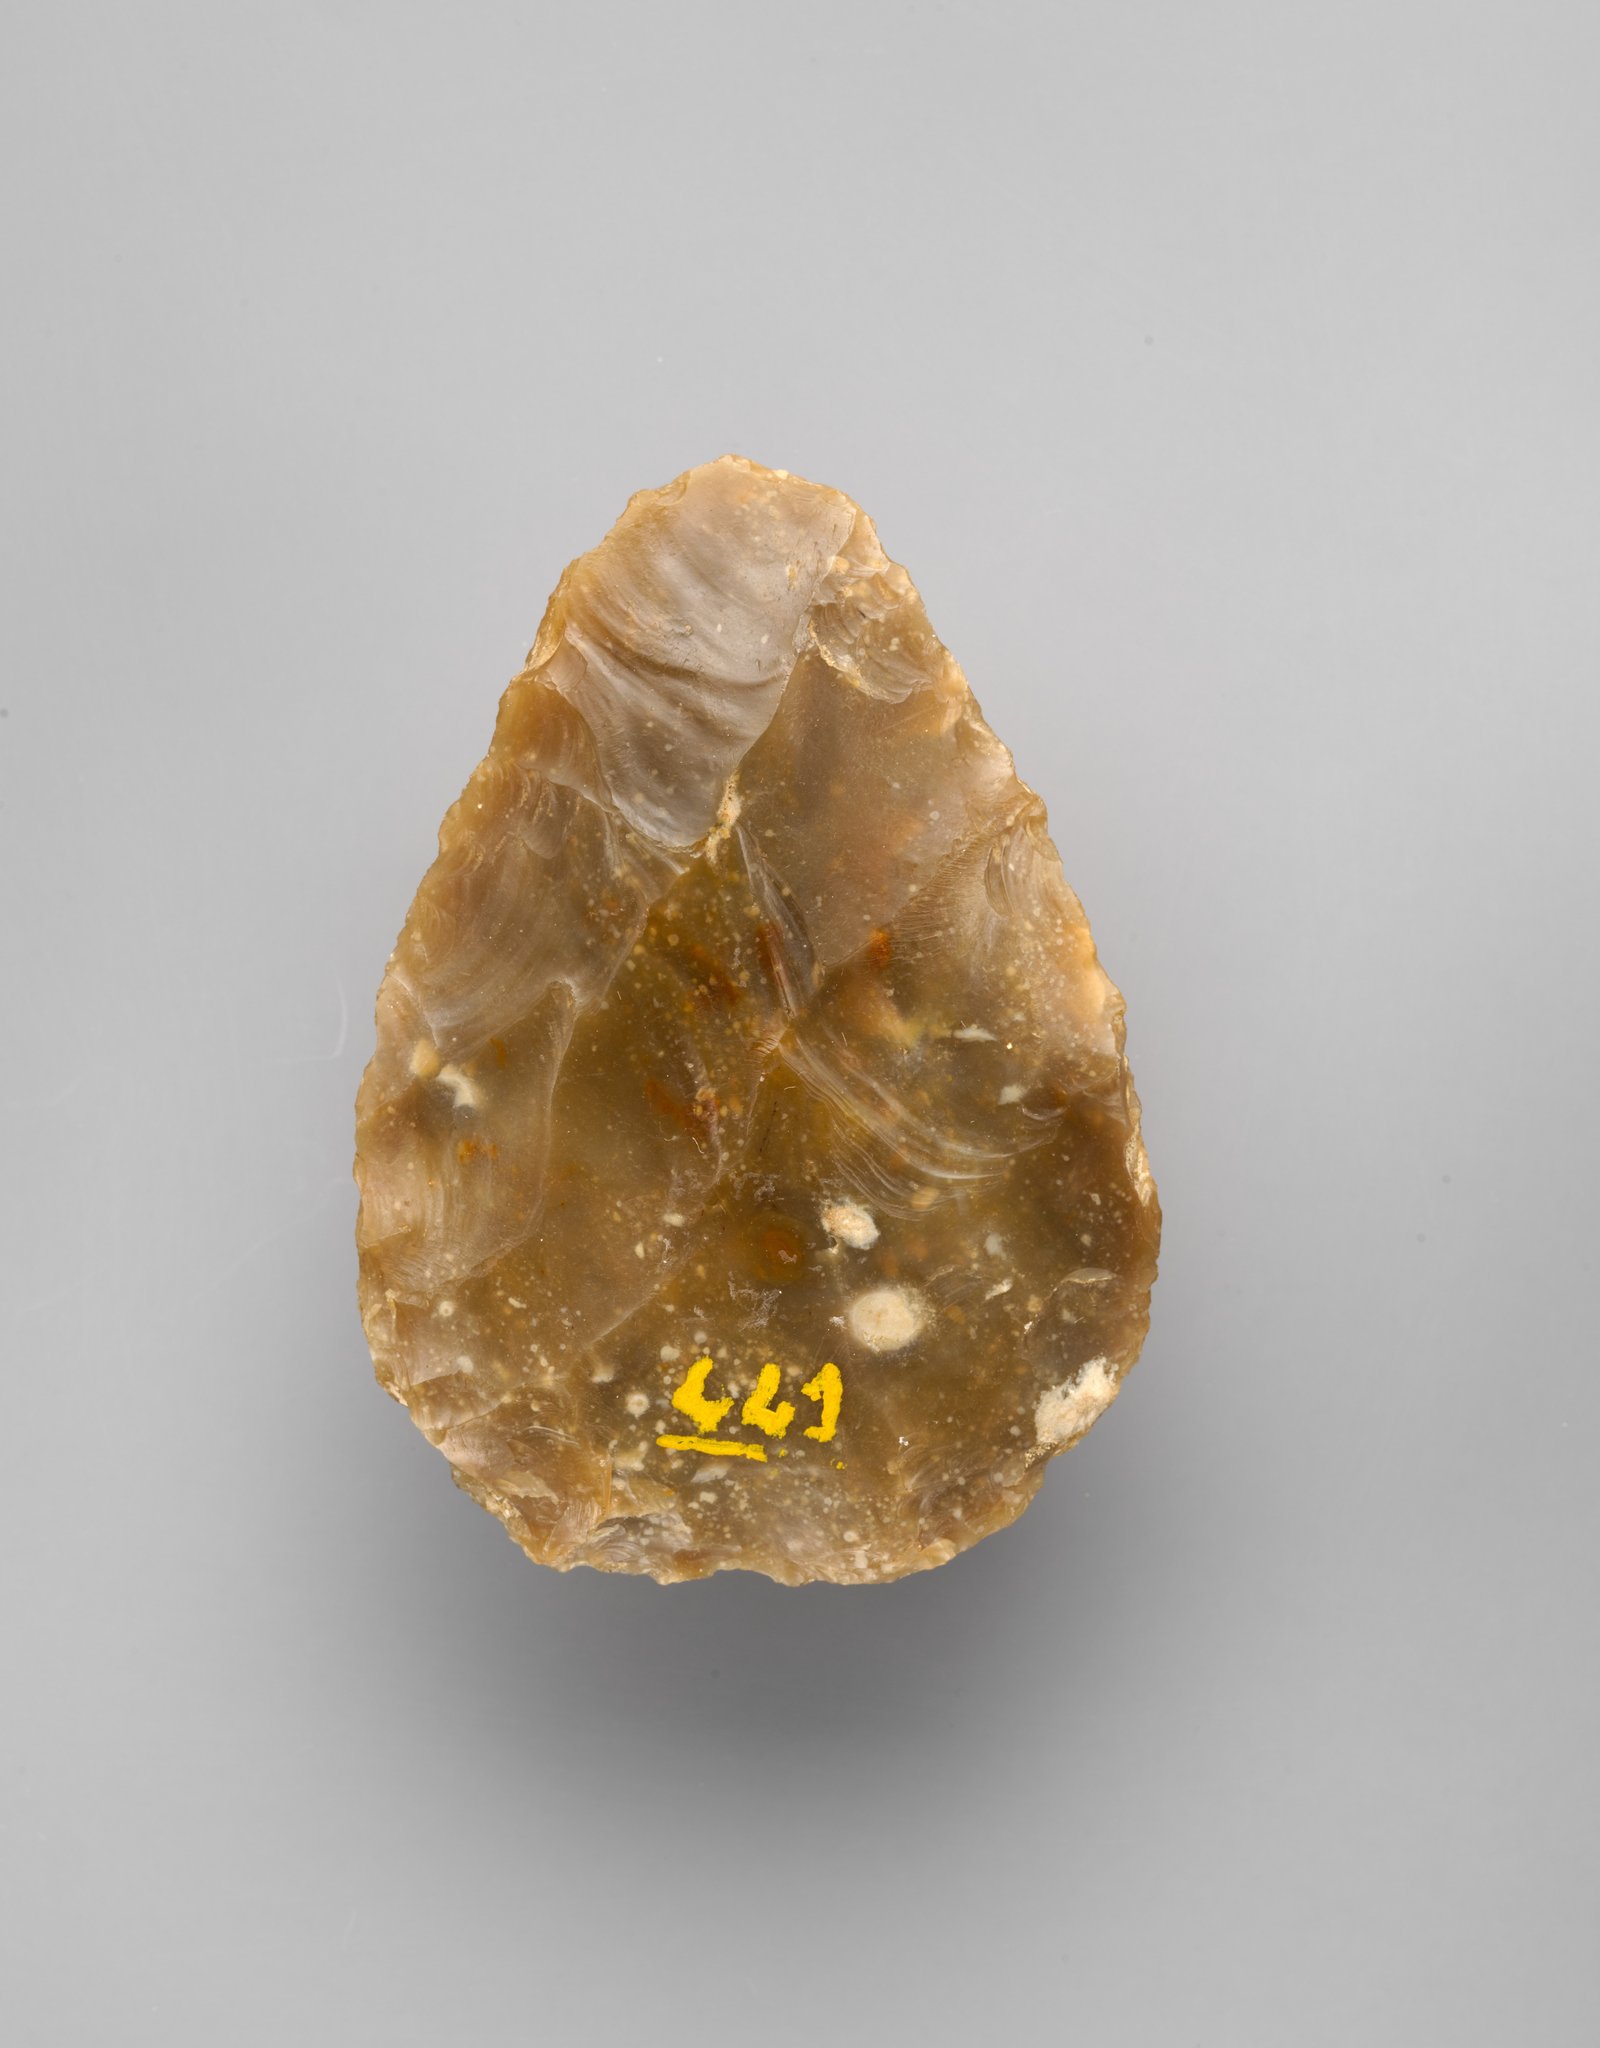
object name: biface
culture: acheulean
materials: stone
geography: france